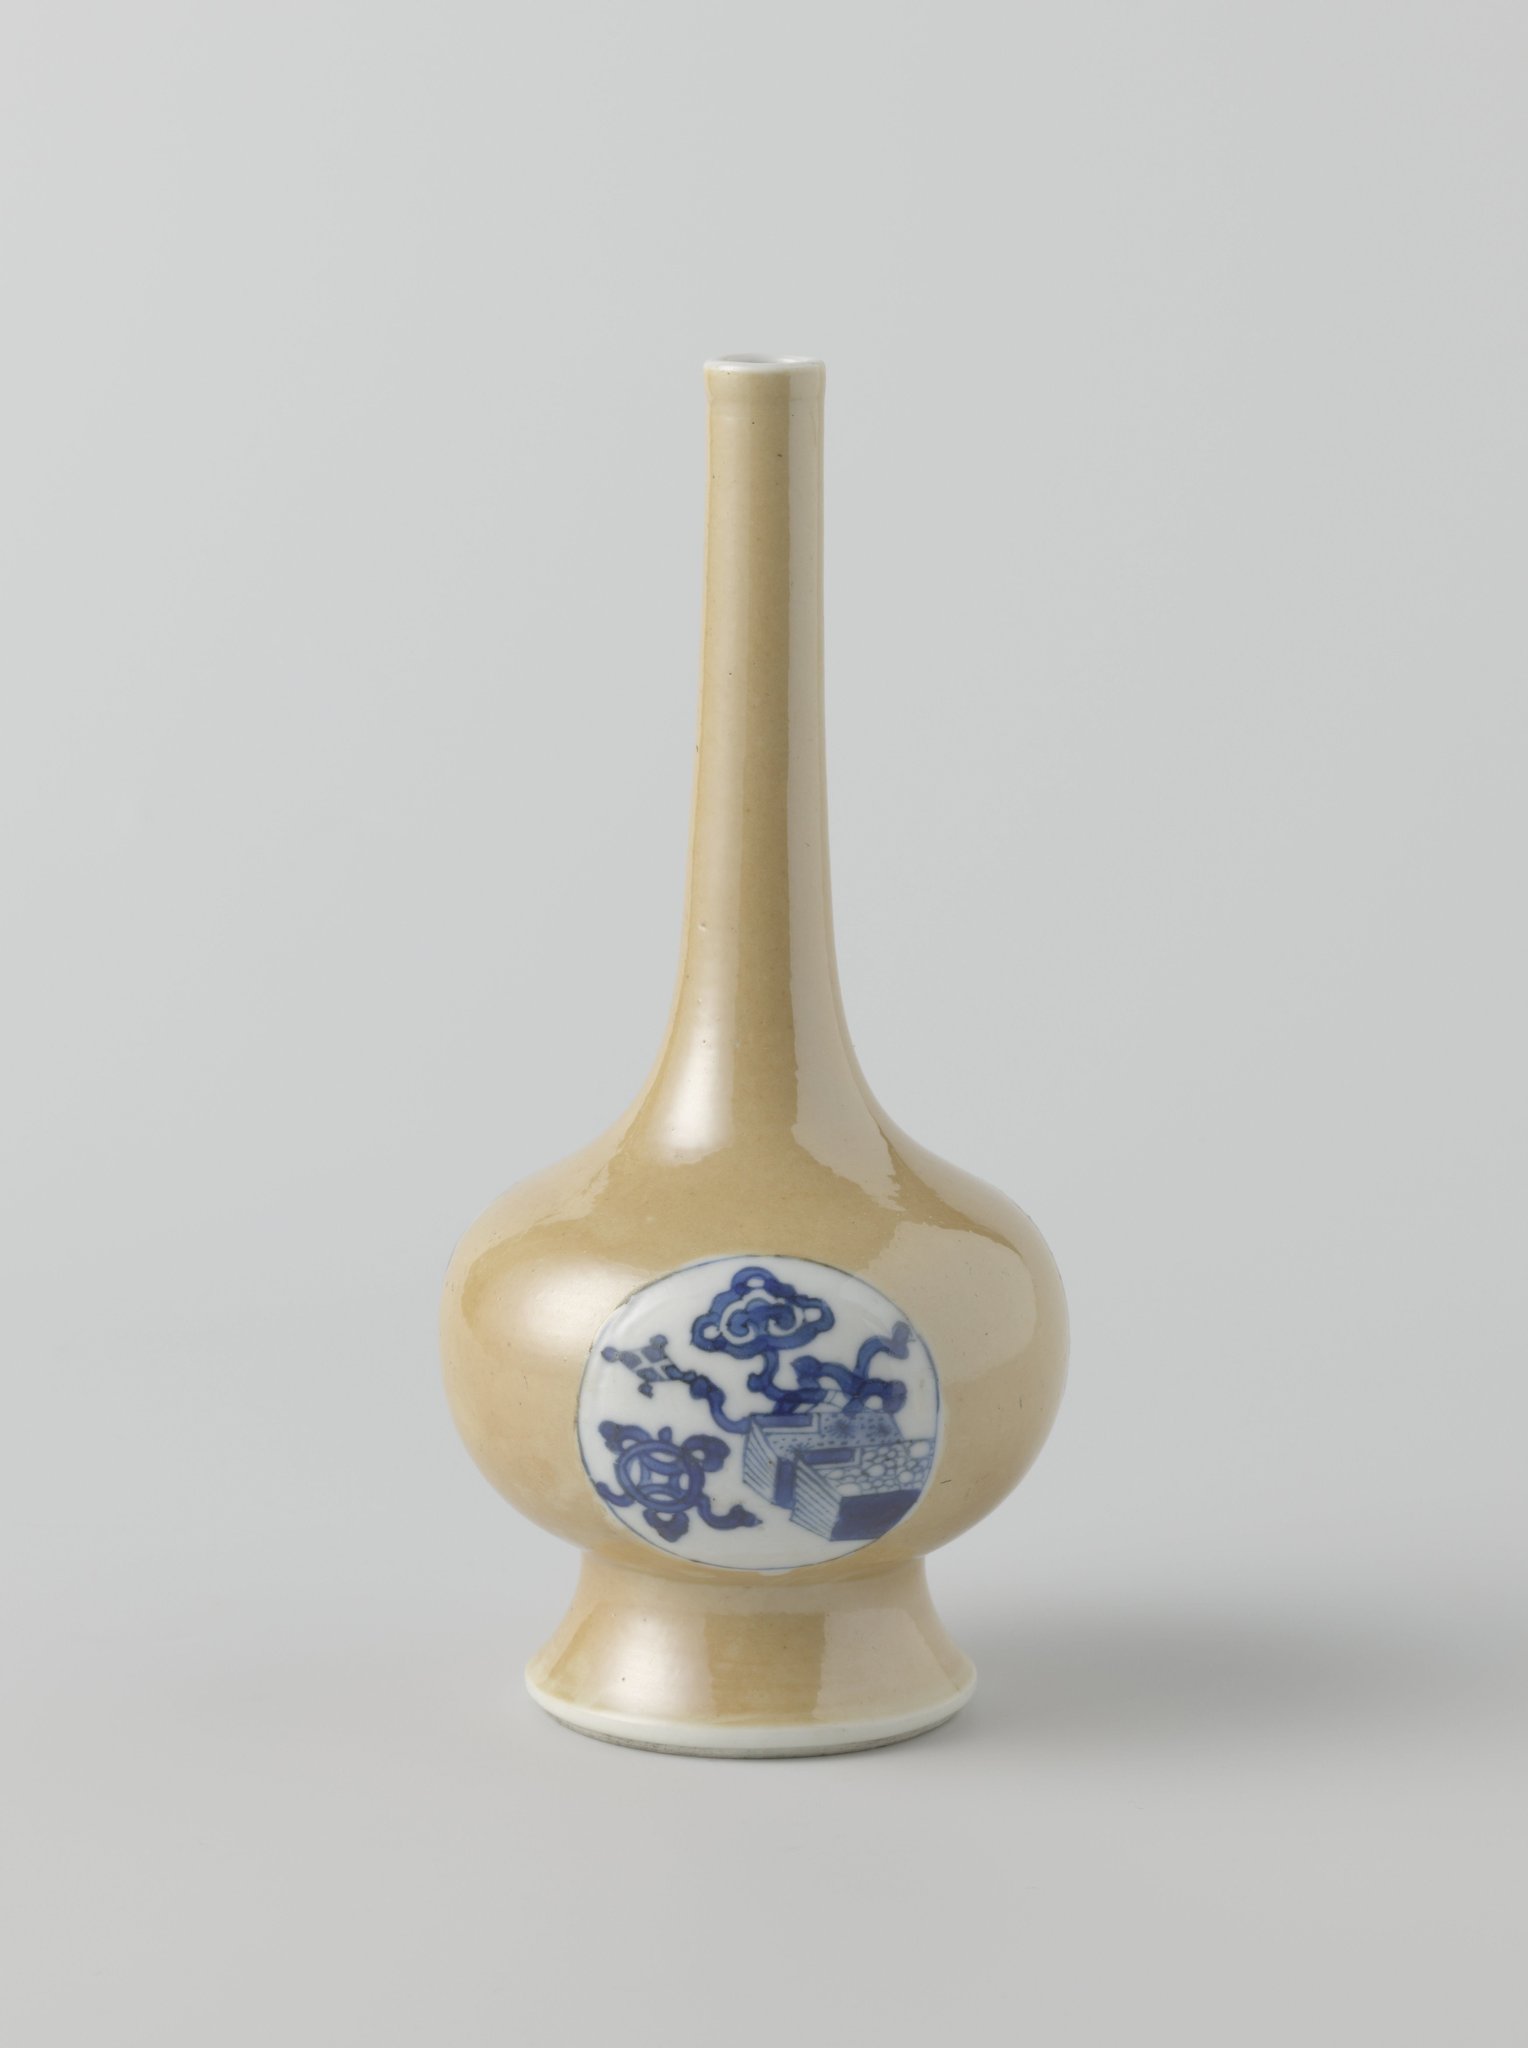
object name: sprinkler flask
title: Rosewater sprinkler or bottle with light brown and auspicious symbols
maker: Anonymous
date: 1700-1724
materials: cobalt, glaze, paint, porcelain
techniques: firing, turning, vitrification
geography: china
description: Rozenwater druppelaar of puntfles op hoge voet van porselein met bolvormig lichaam en lange, smalle nek, bedekt met een café-au-lait glazuur en beschilderd in onderglazuur blauw. Uitgespaard in het lichtbruine glazuur drie ronde velden met gelukssymbolen (rol, parel, artemisiablad, driepoot, boeken, ruyi-scepter, munt, ruit, dubbele bijl, go-bord) in onderglazuur blauw. Monochroom bruin met blauw-wit.